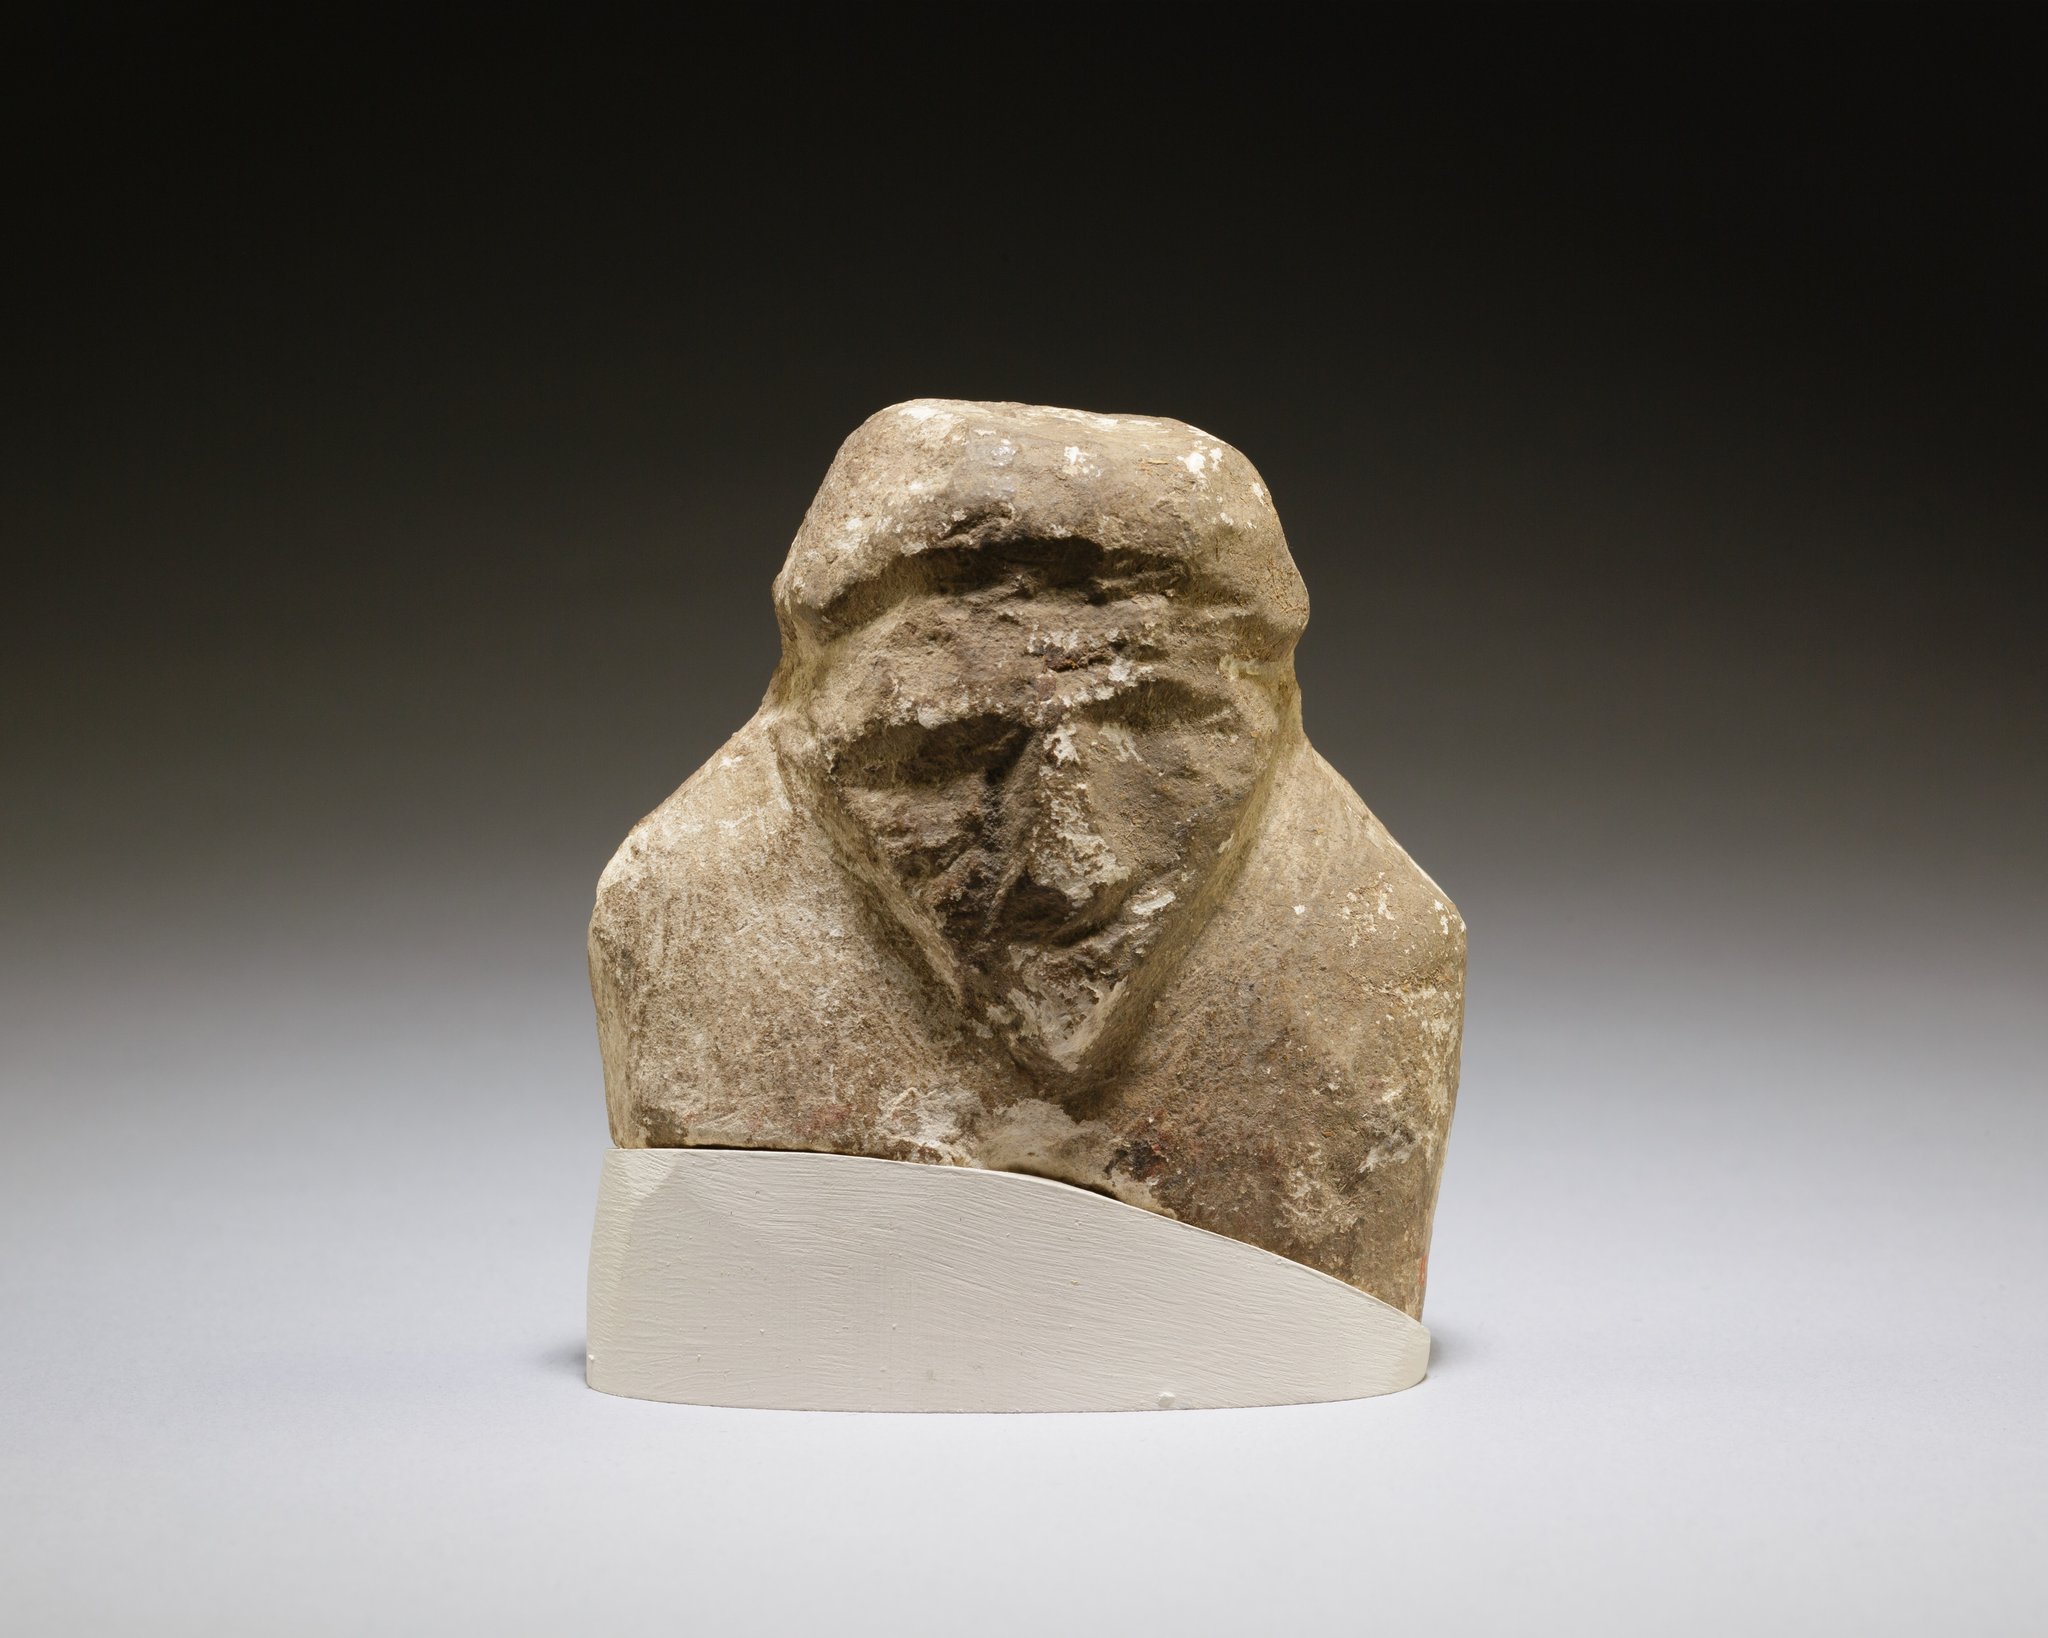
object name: figurine, bust, upper part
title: Magical figurine of foreigner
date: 1981-1650 BCE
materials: limestone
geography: egypt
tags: men